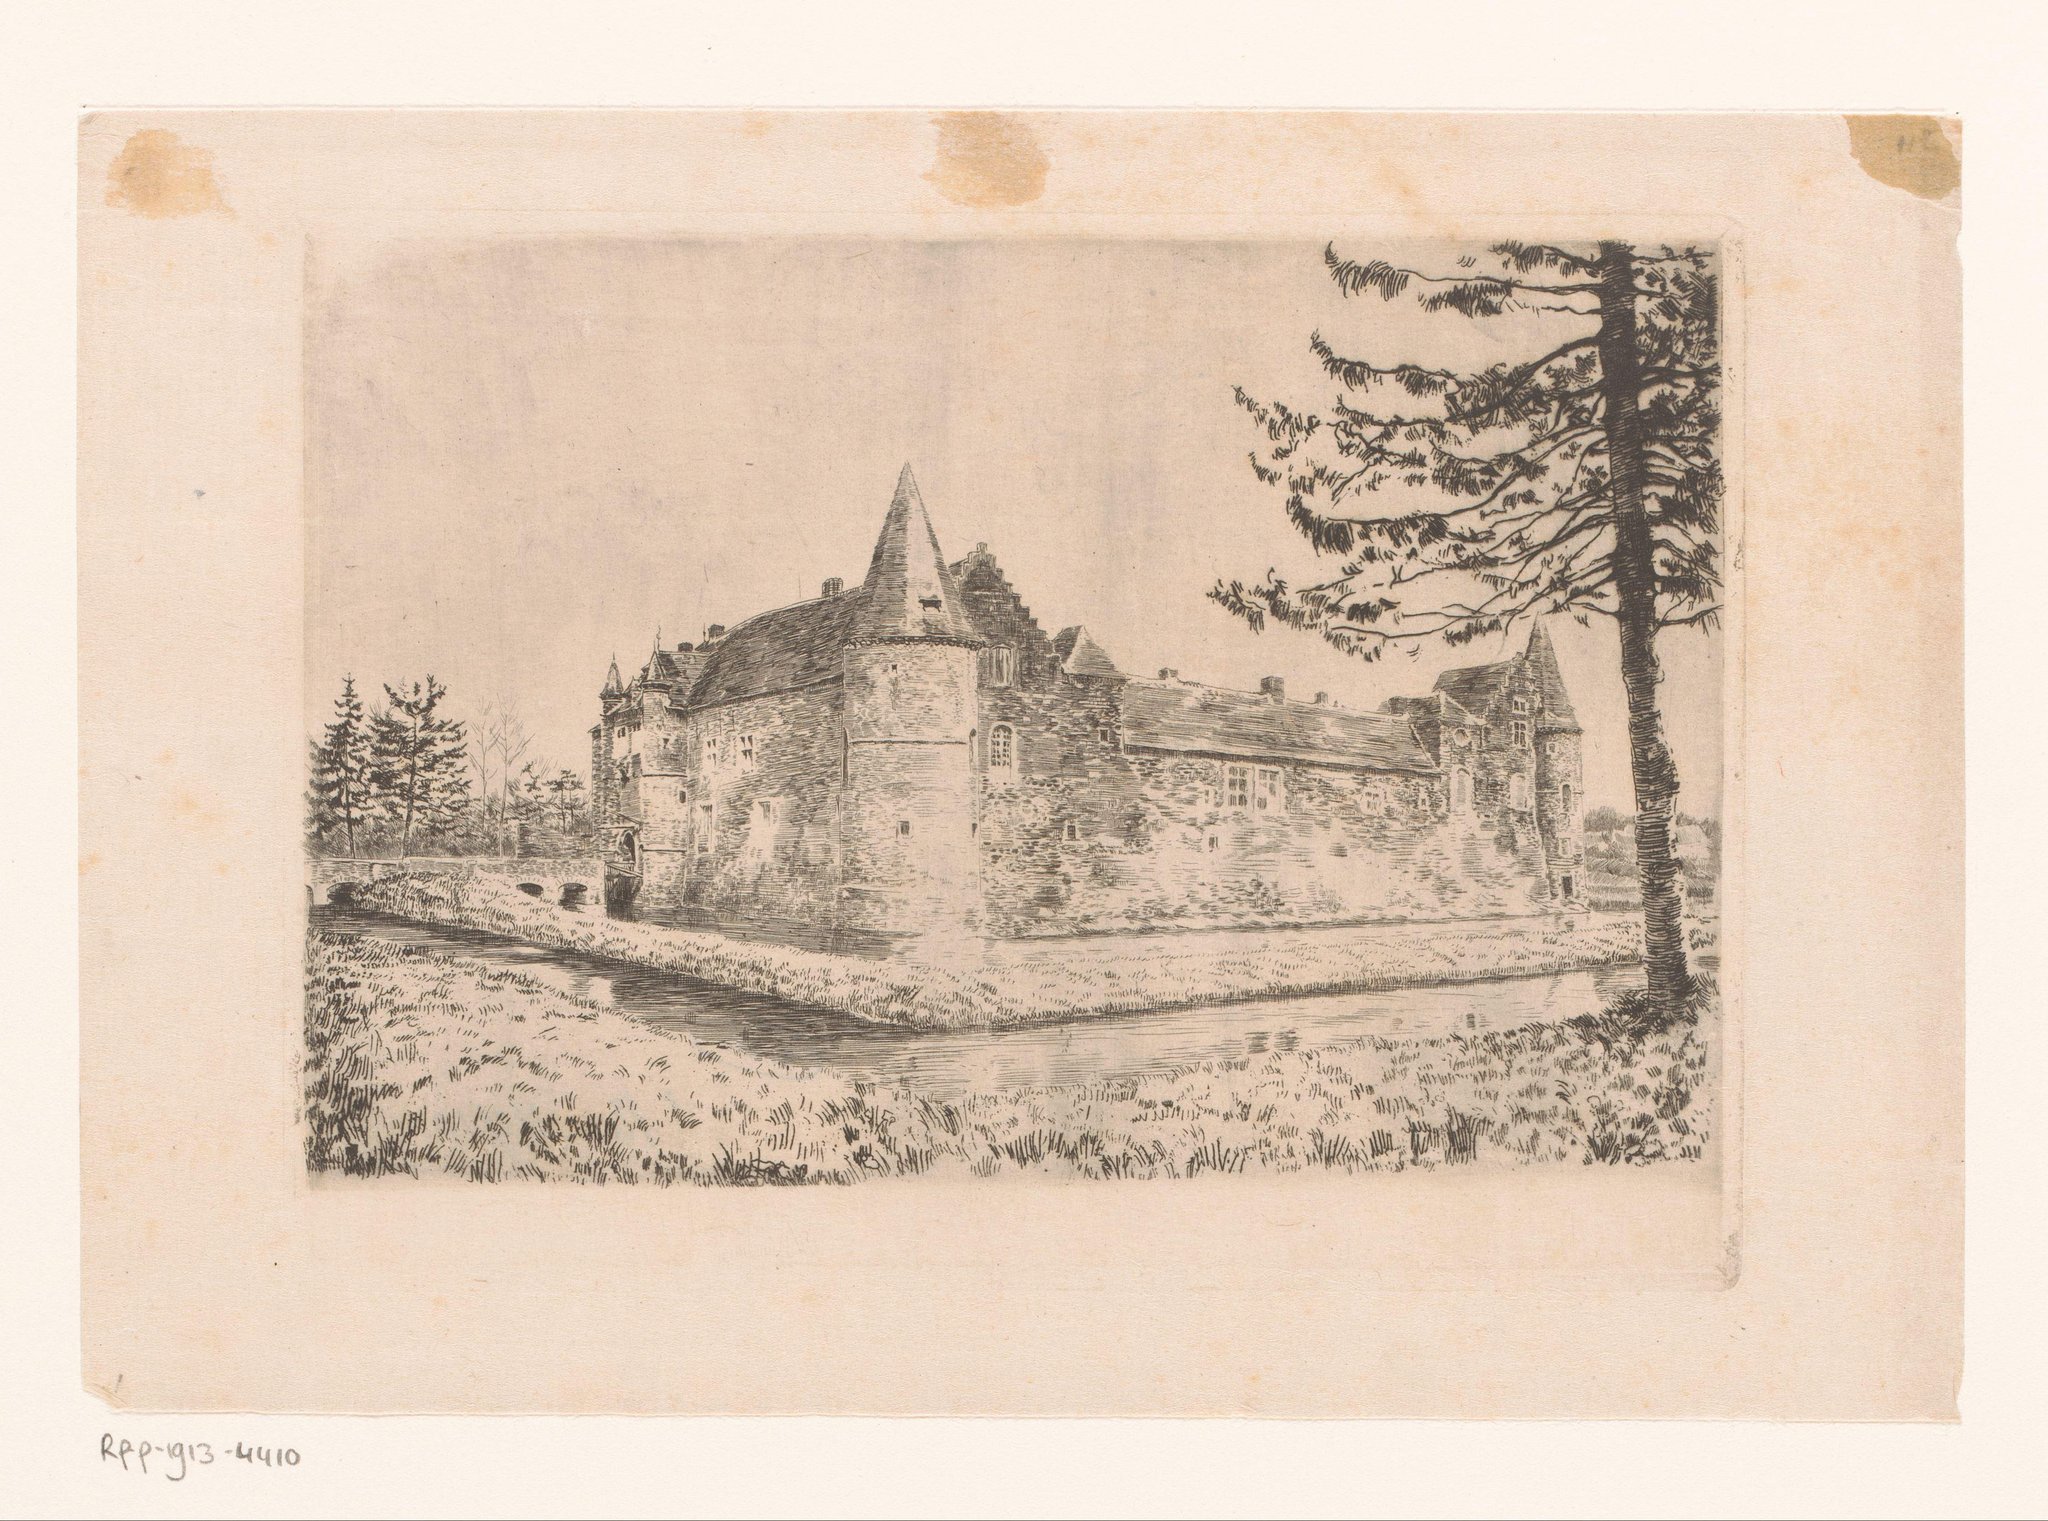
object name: print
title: Kasteel van Fallais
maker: adrien de witte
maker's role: print maker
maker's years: 1850-1935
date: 1860-1913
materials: paper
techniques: drypoint, etching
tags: castle, liège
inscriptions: collector's mark: Lugt 2228